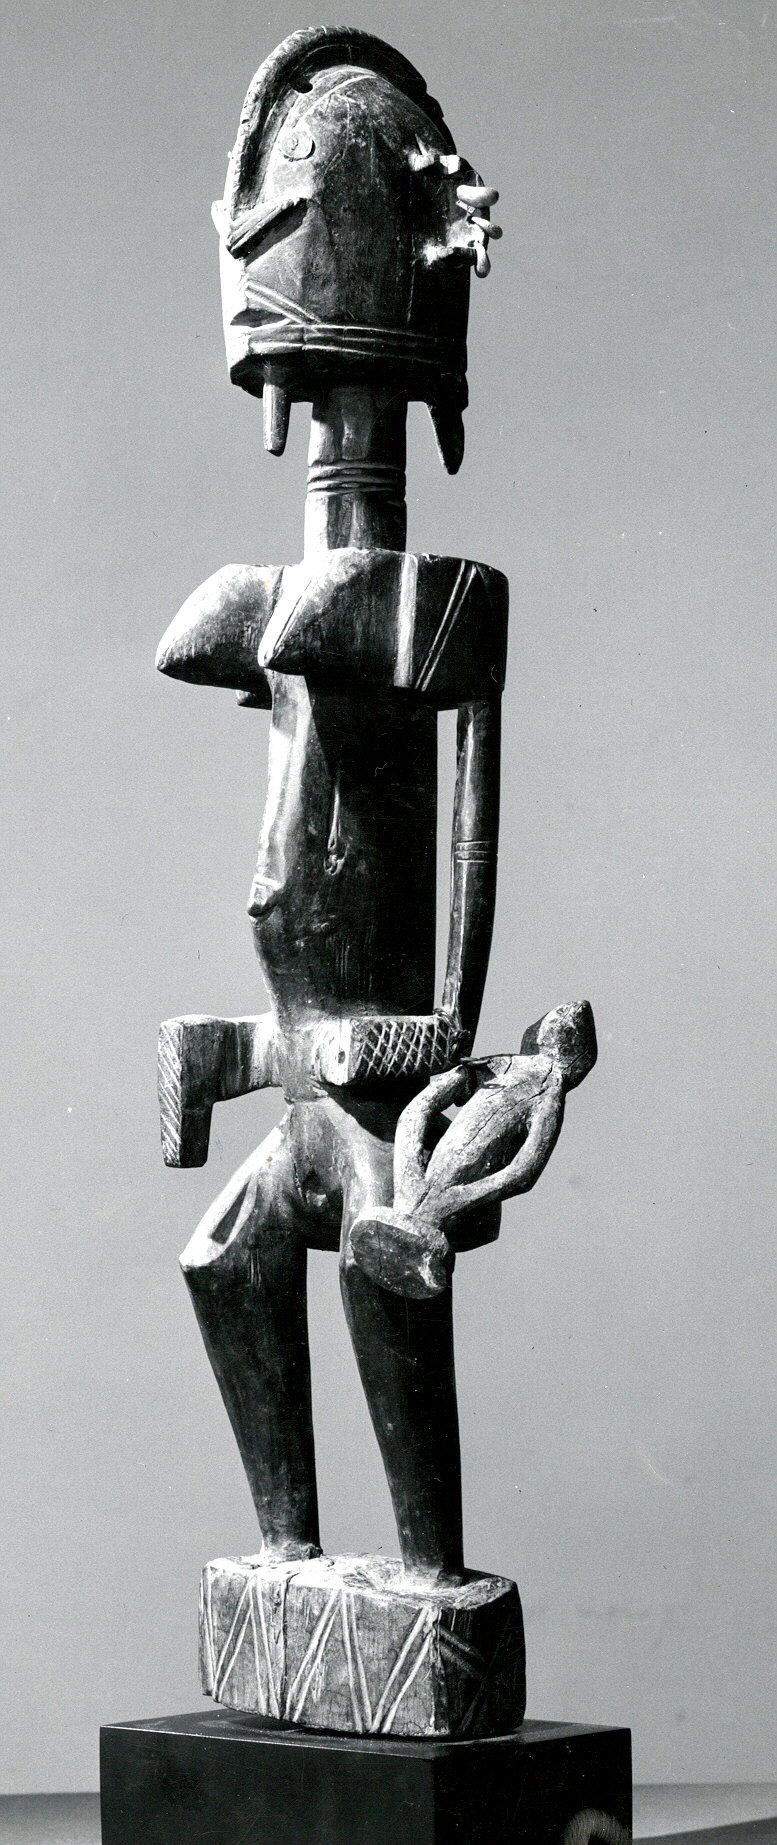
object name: figure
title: Female with Small Figure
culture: dogon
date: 1401-1900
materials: leather, metal, wood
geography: mali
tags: women